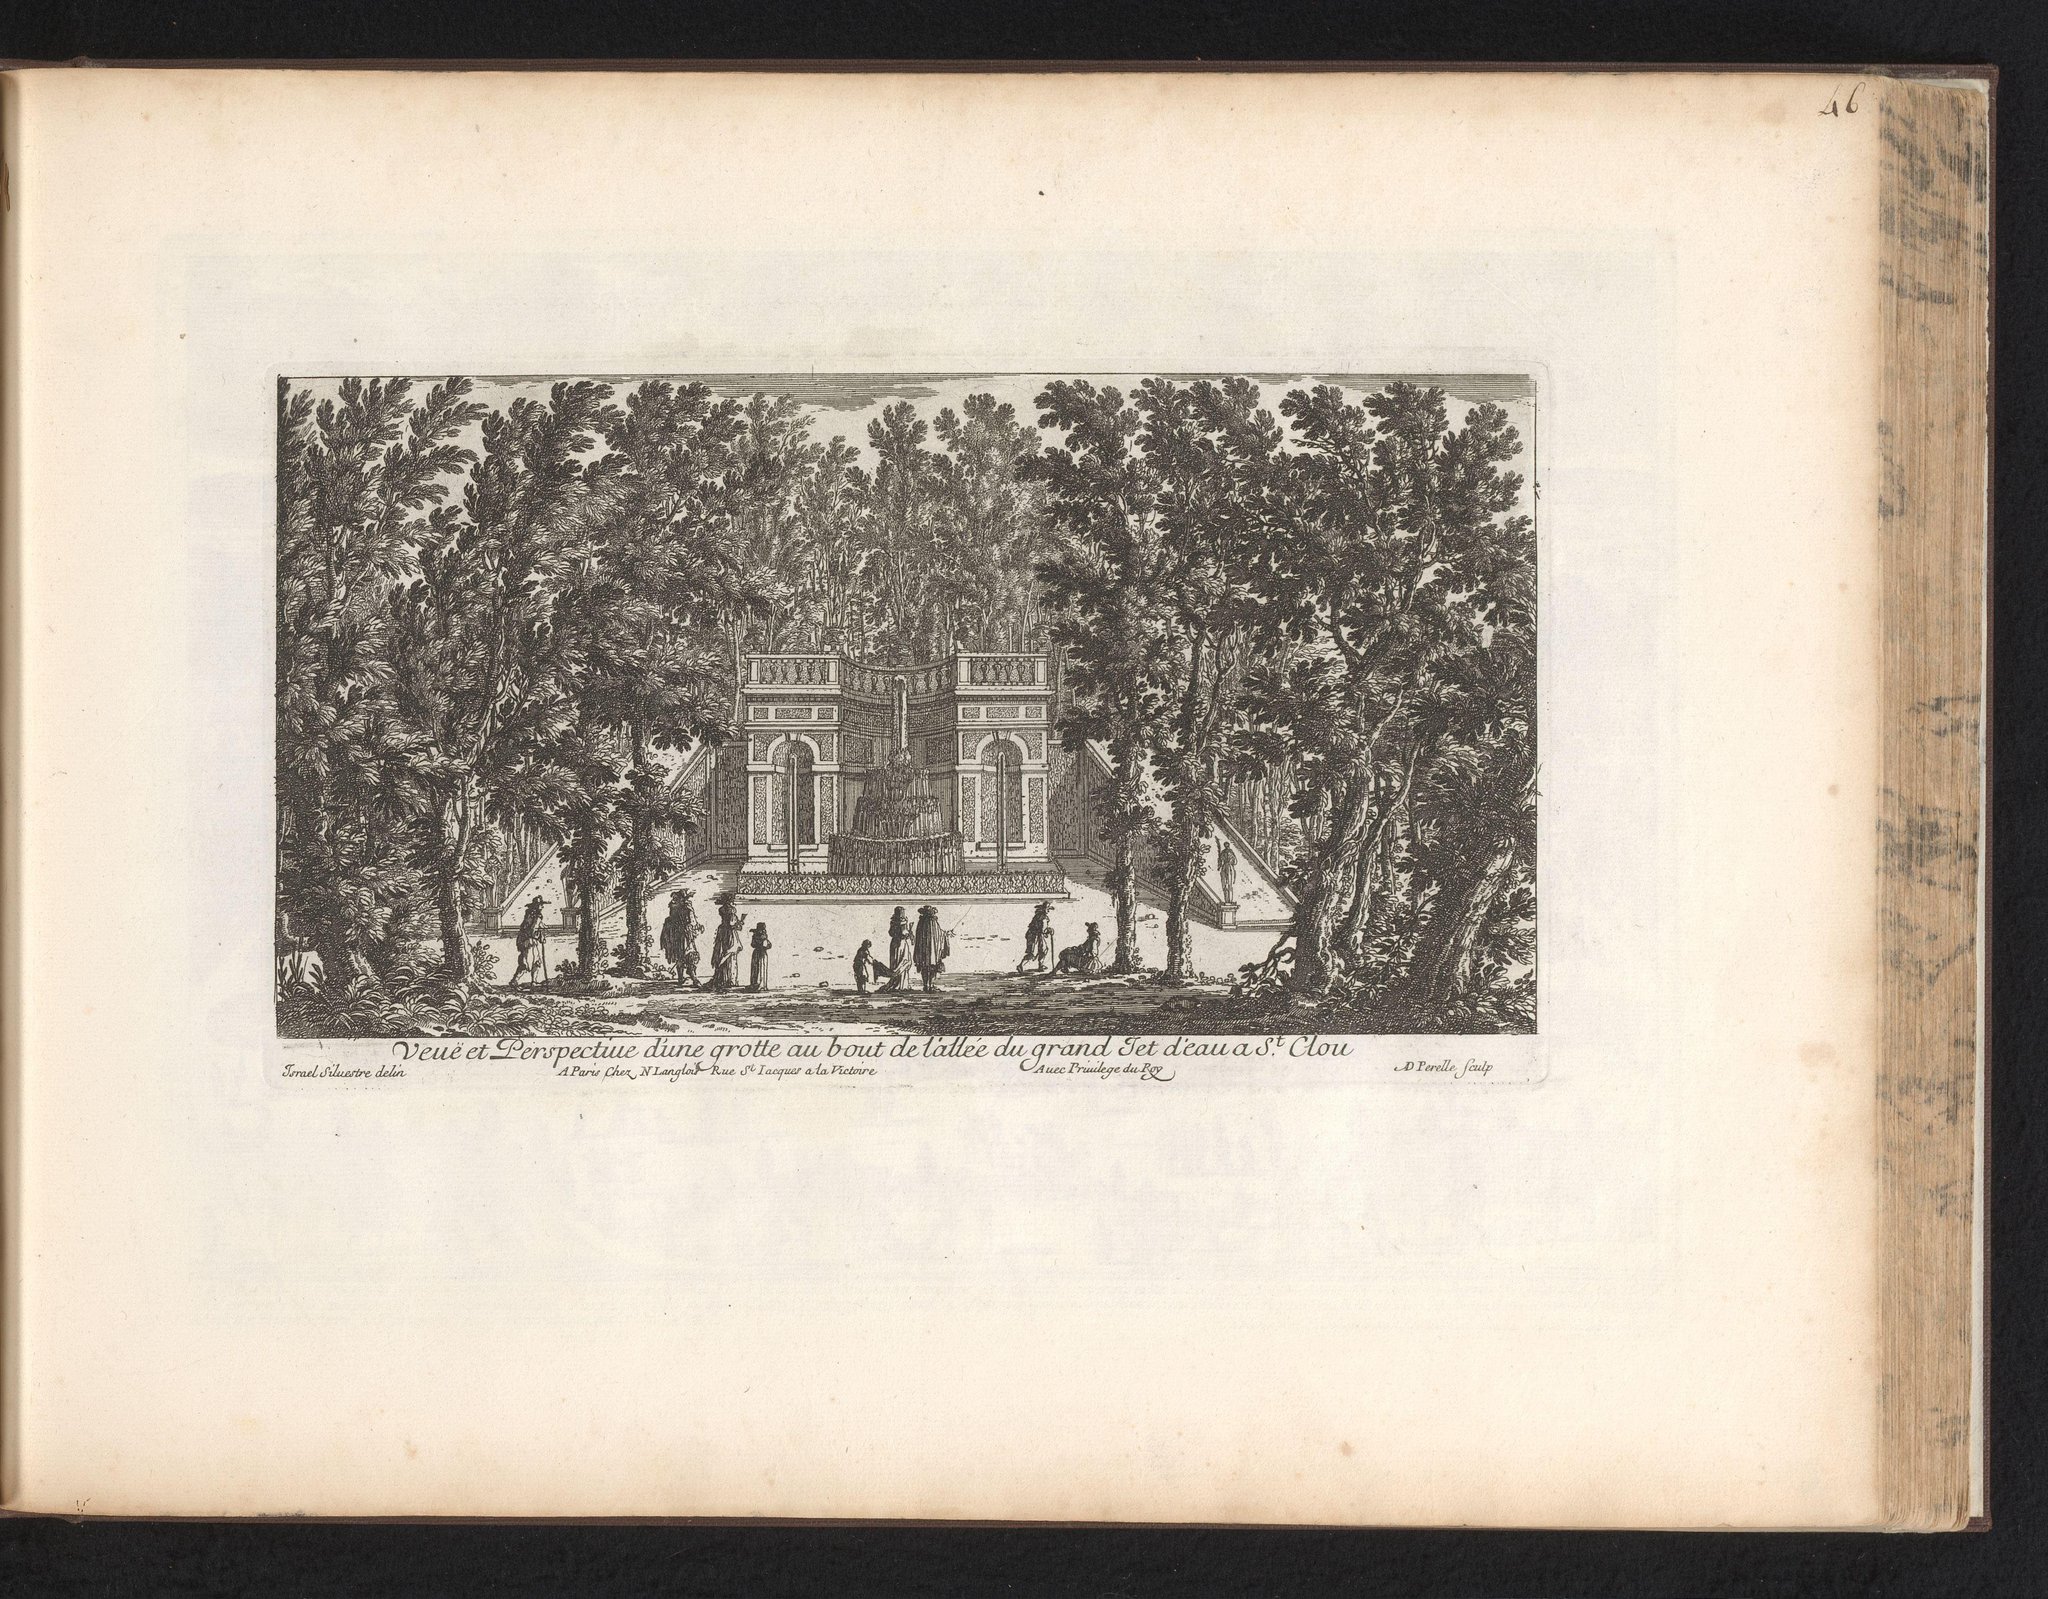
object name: album leaf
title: Veuë et Perspective d'une grotte (...)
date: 1648-1707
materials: paper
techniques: etching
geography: france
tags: artificial grotto in garden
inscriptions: collector's mark: Lugt 2228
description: Prenten met het signatuur 'Perelle' kunnen zowel door vader Gabriel als door zonen Nicolas en Adam gemaakt zijn. De uitgevers vader en zoon Nicolas Langlois worden allebei vermeld als N. Langlois op hetzelfde adres.